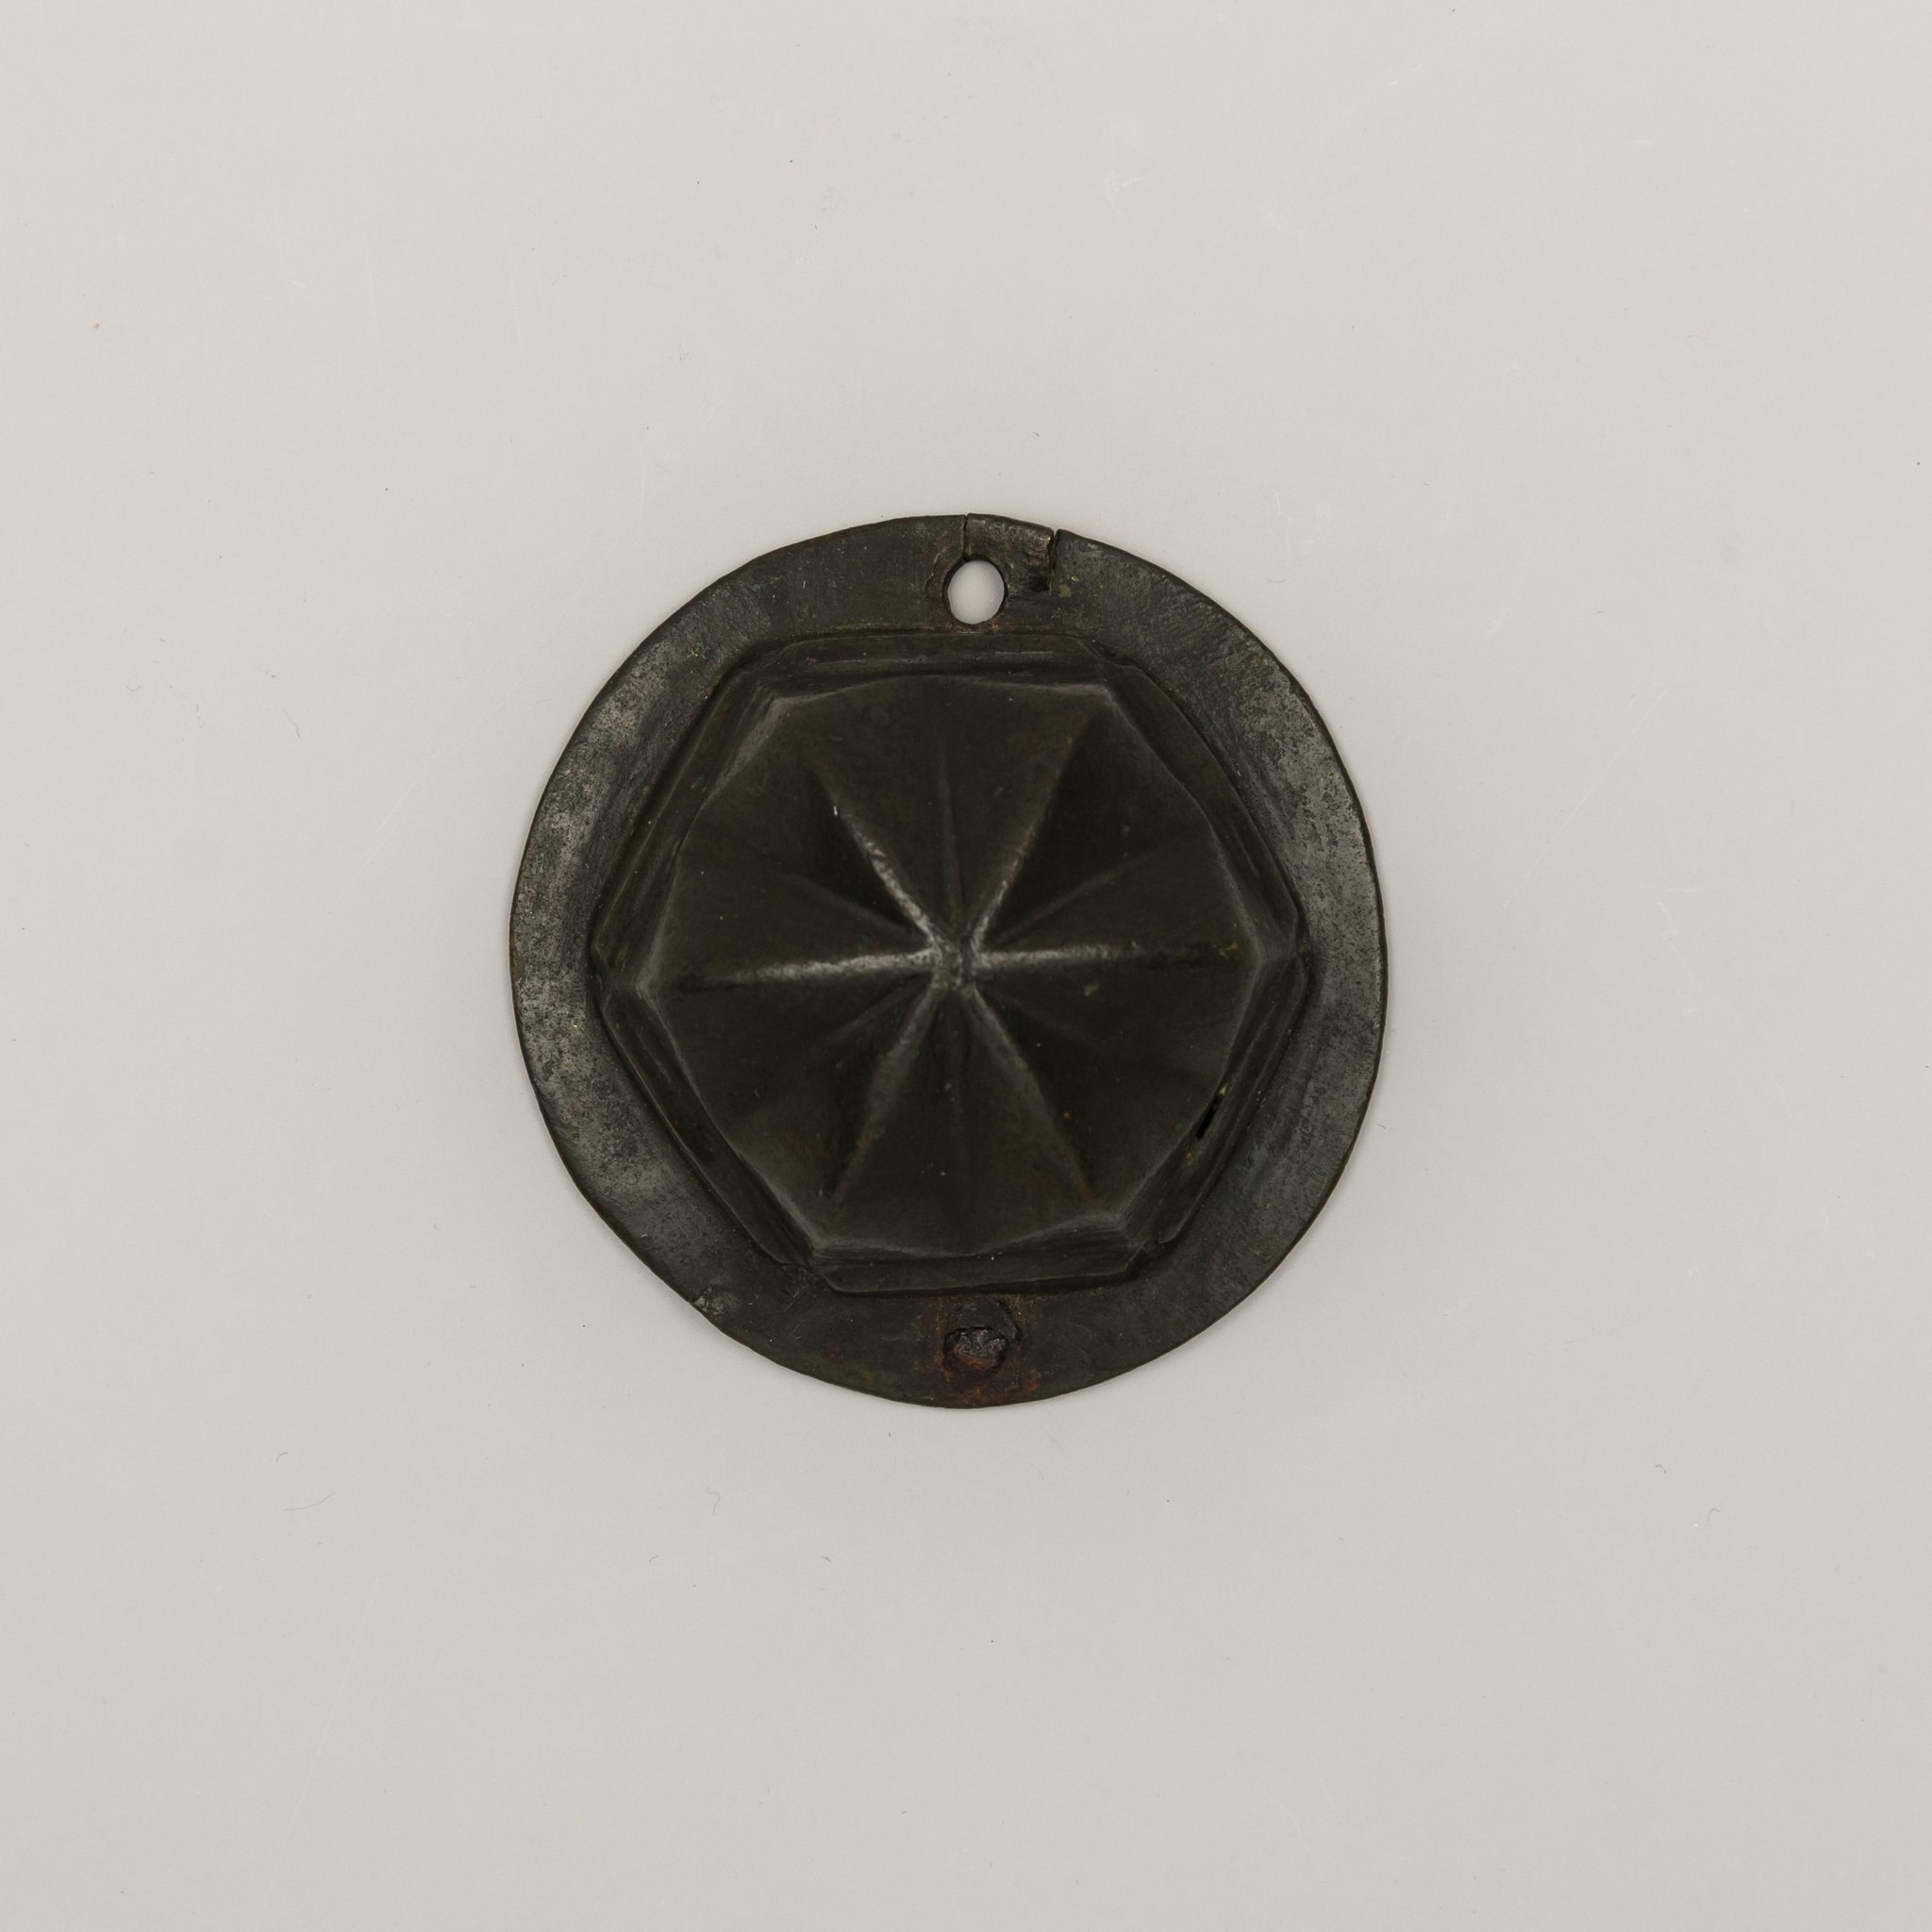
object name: bit bos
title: Bit Boss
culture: european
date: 1501-1600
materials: copper alloy, iron